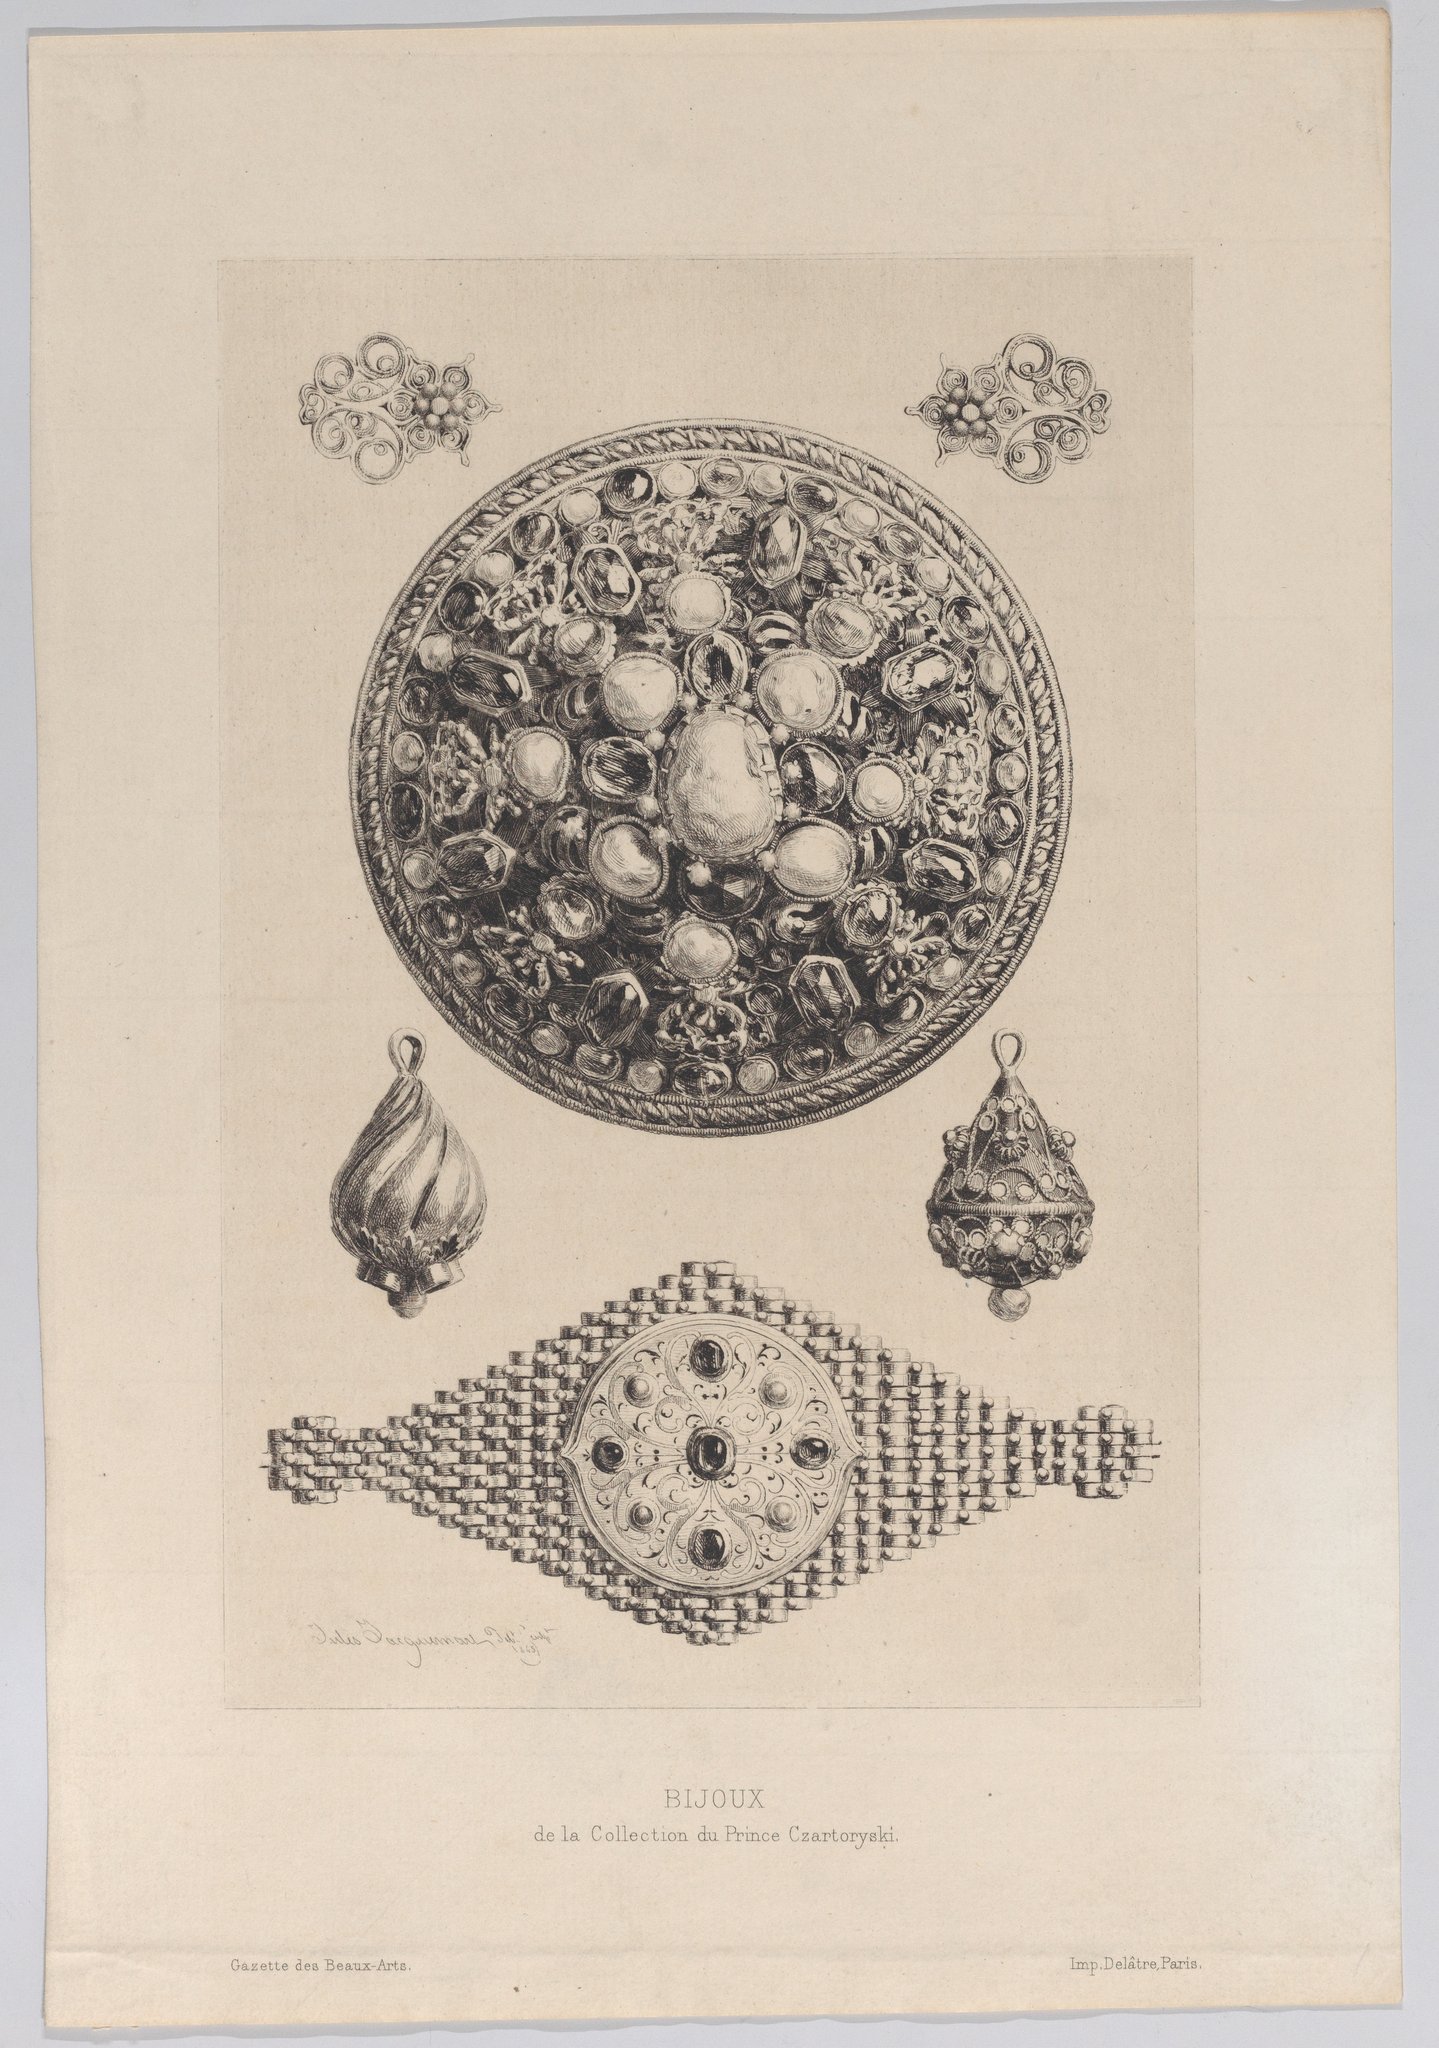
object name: print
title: Bijoux, from the Collection of Prince Czartoryski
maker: jules-ferdinand jacquemart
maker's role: artist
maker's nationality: french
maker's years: 1837-1880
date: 1865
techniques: etching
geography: paris